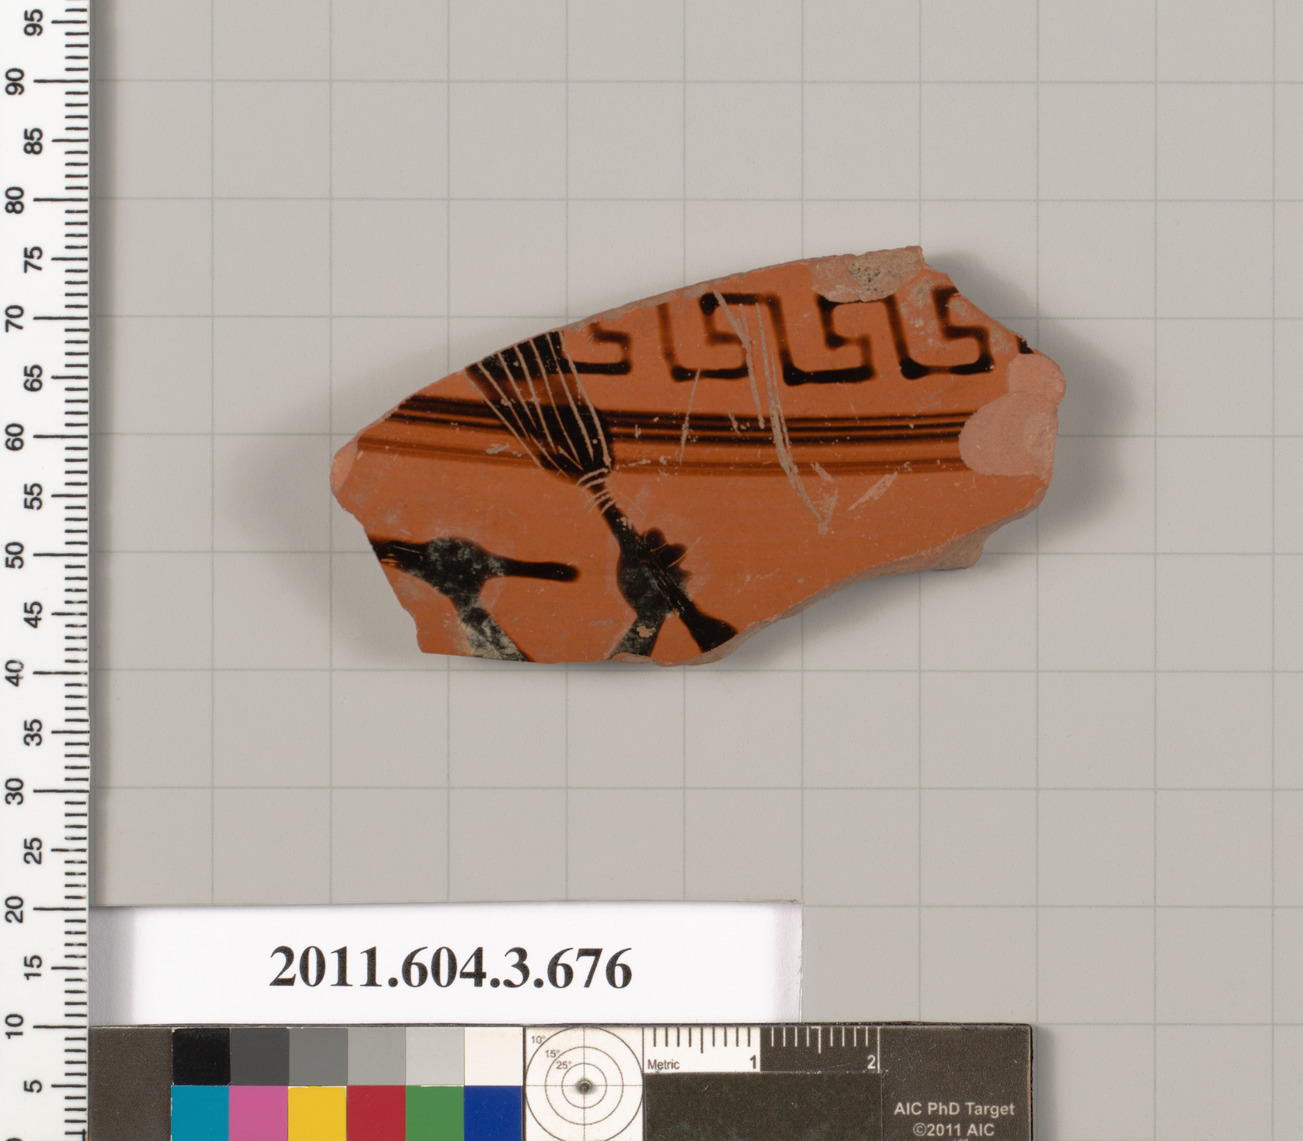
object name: stamnos fragment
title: Terracotta fragment of a stamnos (jar)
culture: greek, attic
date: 510-500 BCE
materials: terracotta